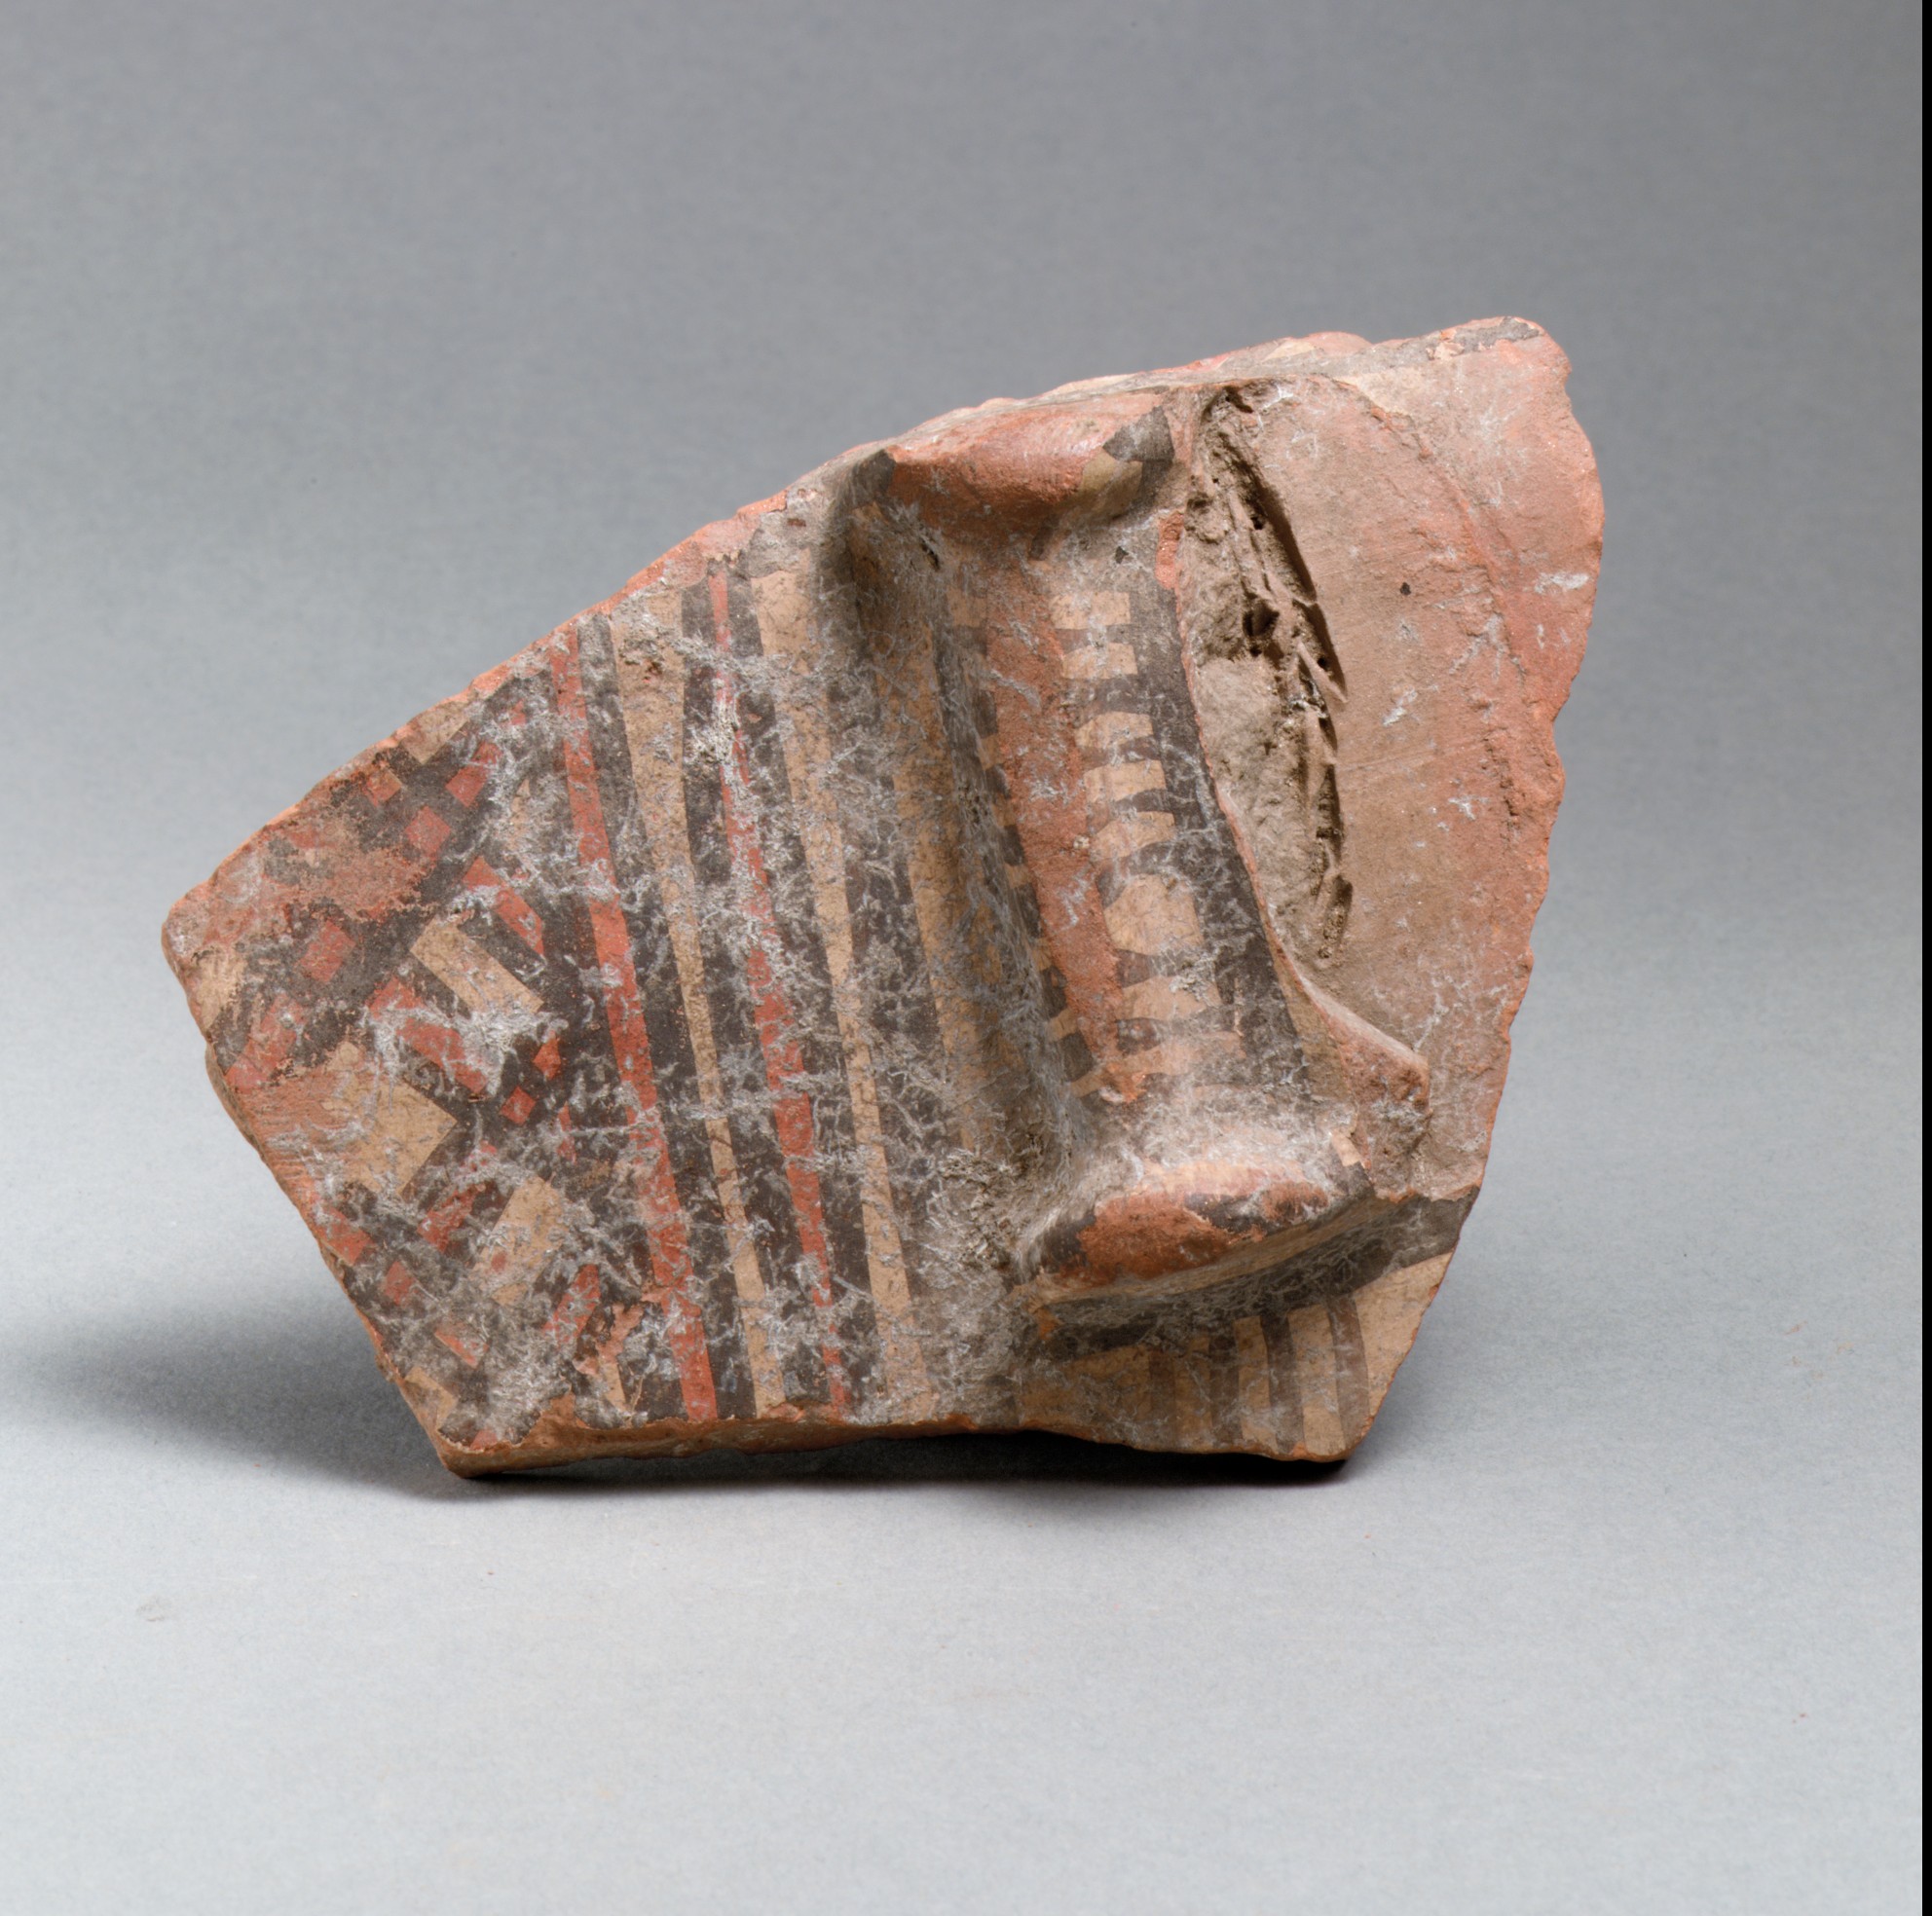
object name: vase fragment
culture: greek or lydian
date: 700-601 BCE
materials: terracotta